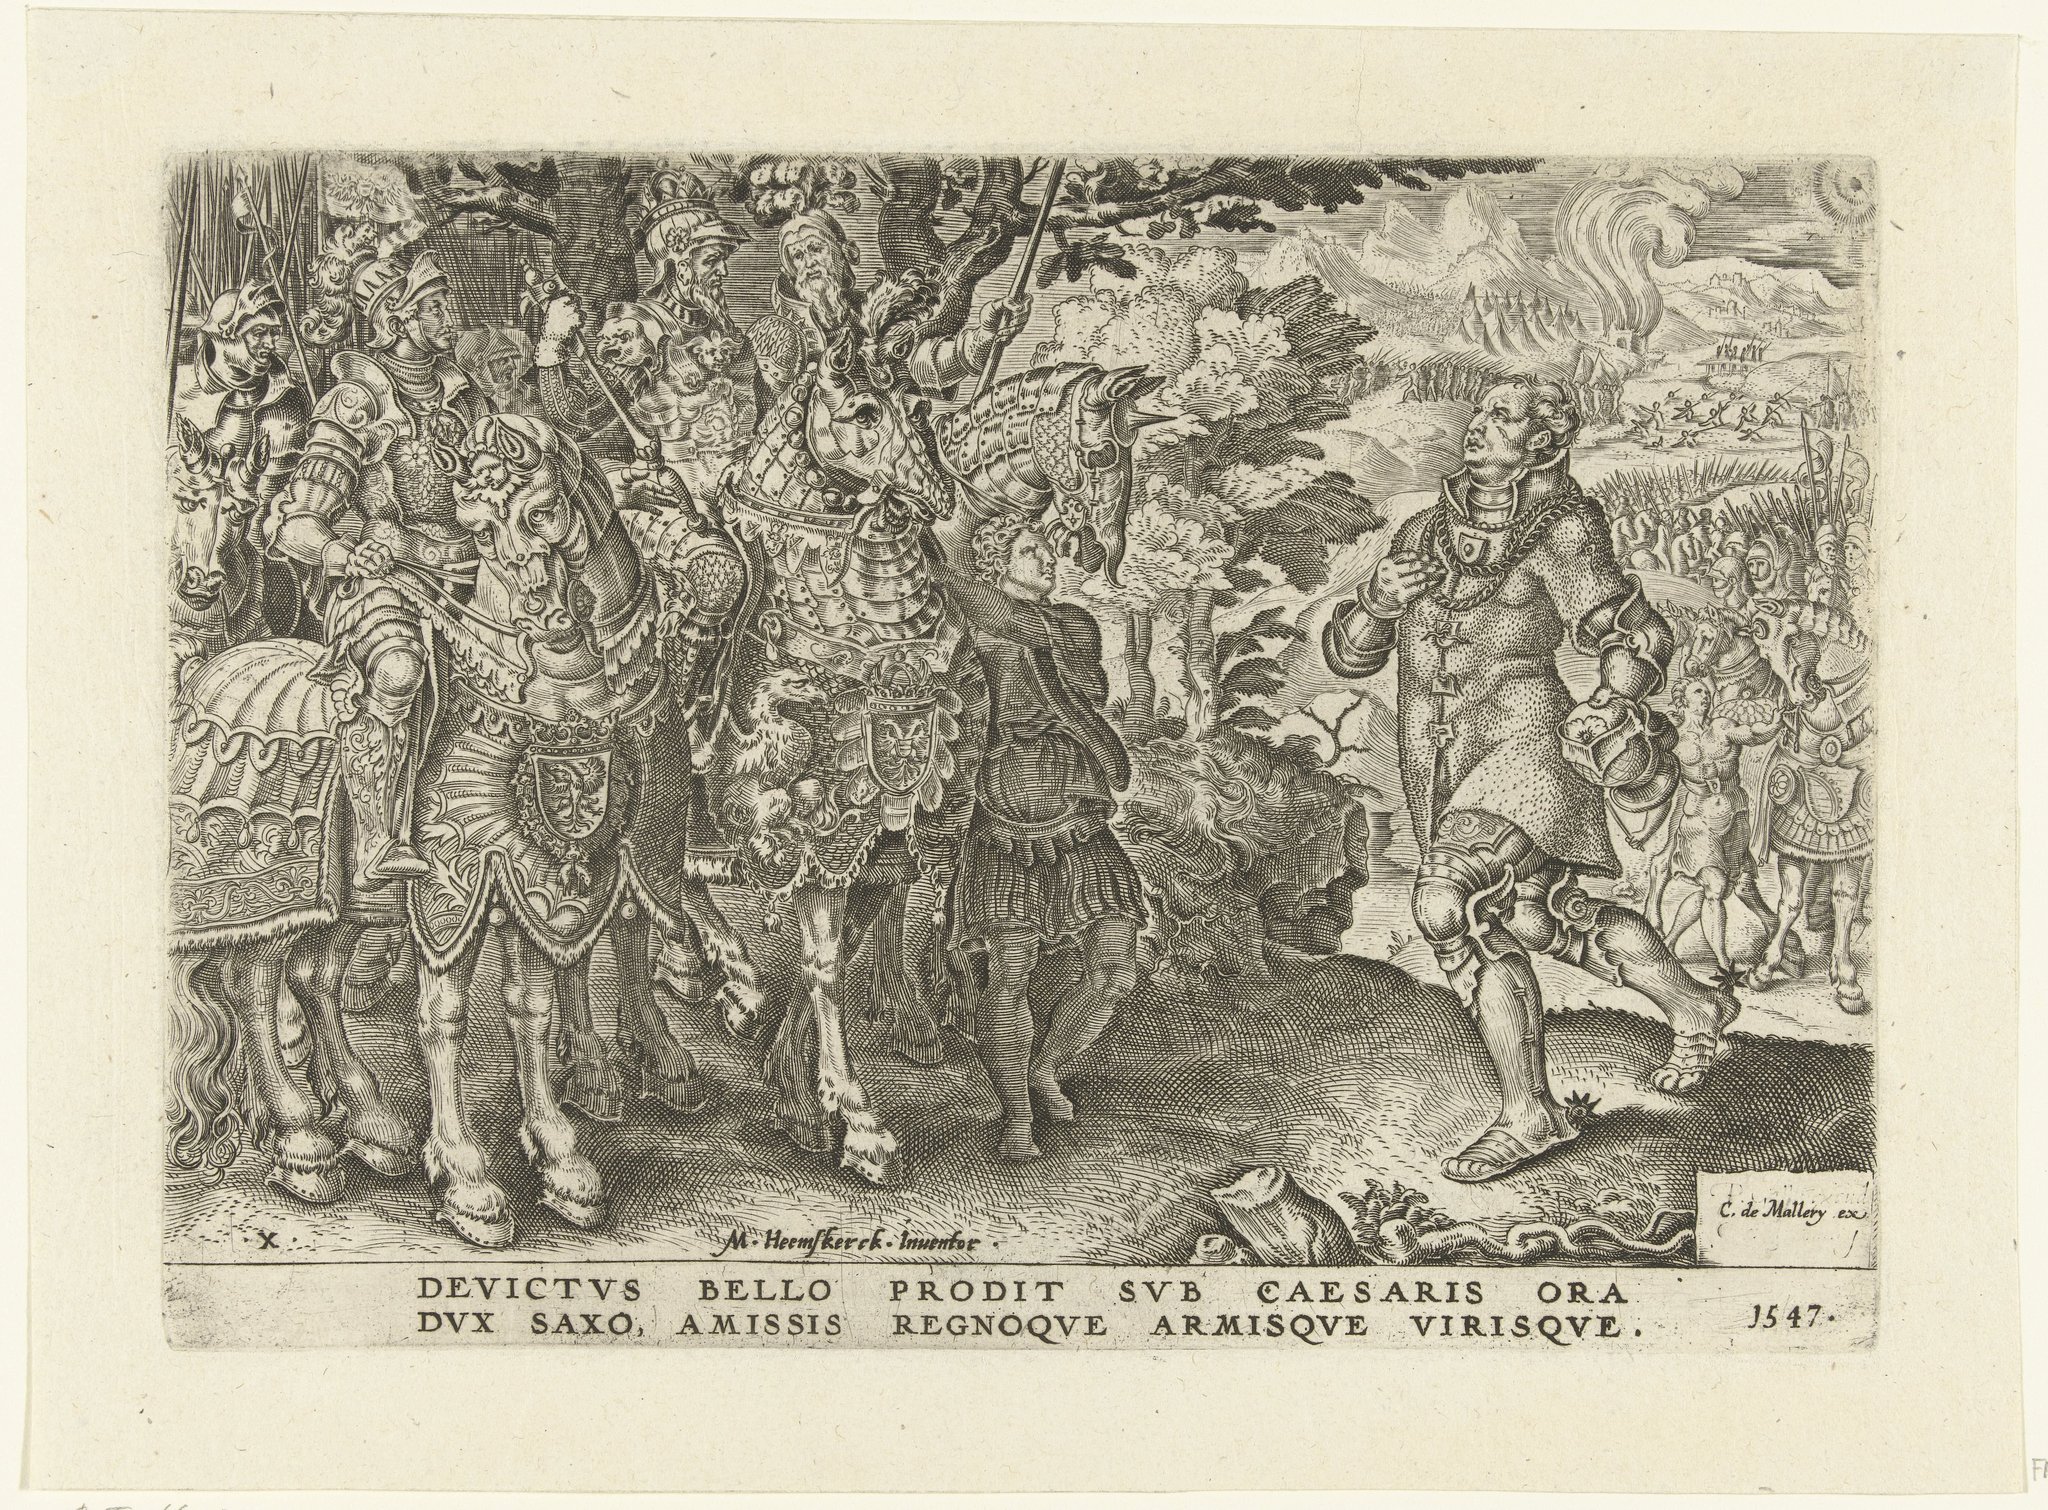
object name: print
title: Overwinningen van Karel V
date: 1555-1556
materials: paper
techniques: engraving, etching, letterpress printing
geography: antwerp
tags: fernando álvarez de toledo (3rd duke of alba), ghent, charles v (holy roman emperor and king of spain), vienna, ferdinand i van habsburg (duits keizer), battle of mühlberg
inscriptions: collector's mark: Lugt 2228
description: Overgave van Johan Frederik de Grootmoedige, keurvorst van Saksen na de nederlaag bij de Slag bij Mühlberg in 1547. De hertog te voet voor keizer Karel V tussen zijn bevelhebbers te paard. Onderschrift in twee regels Latijn.